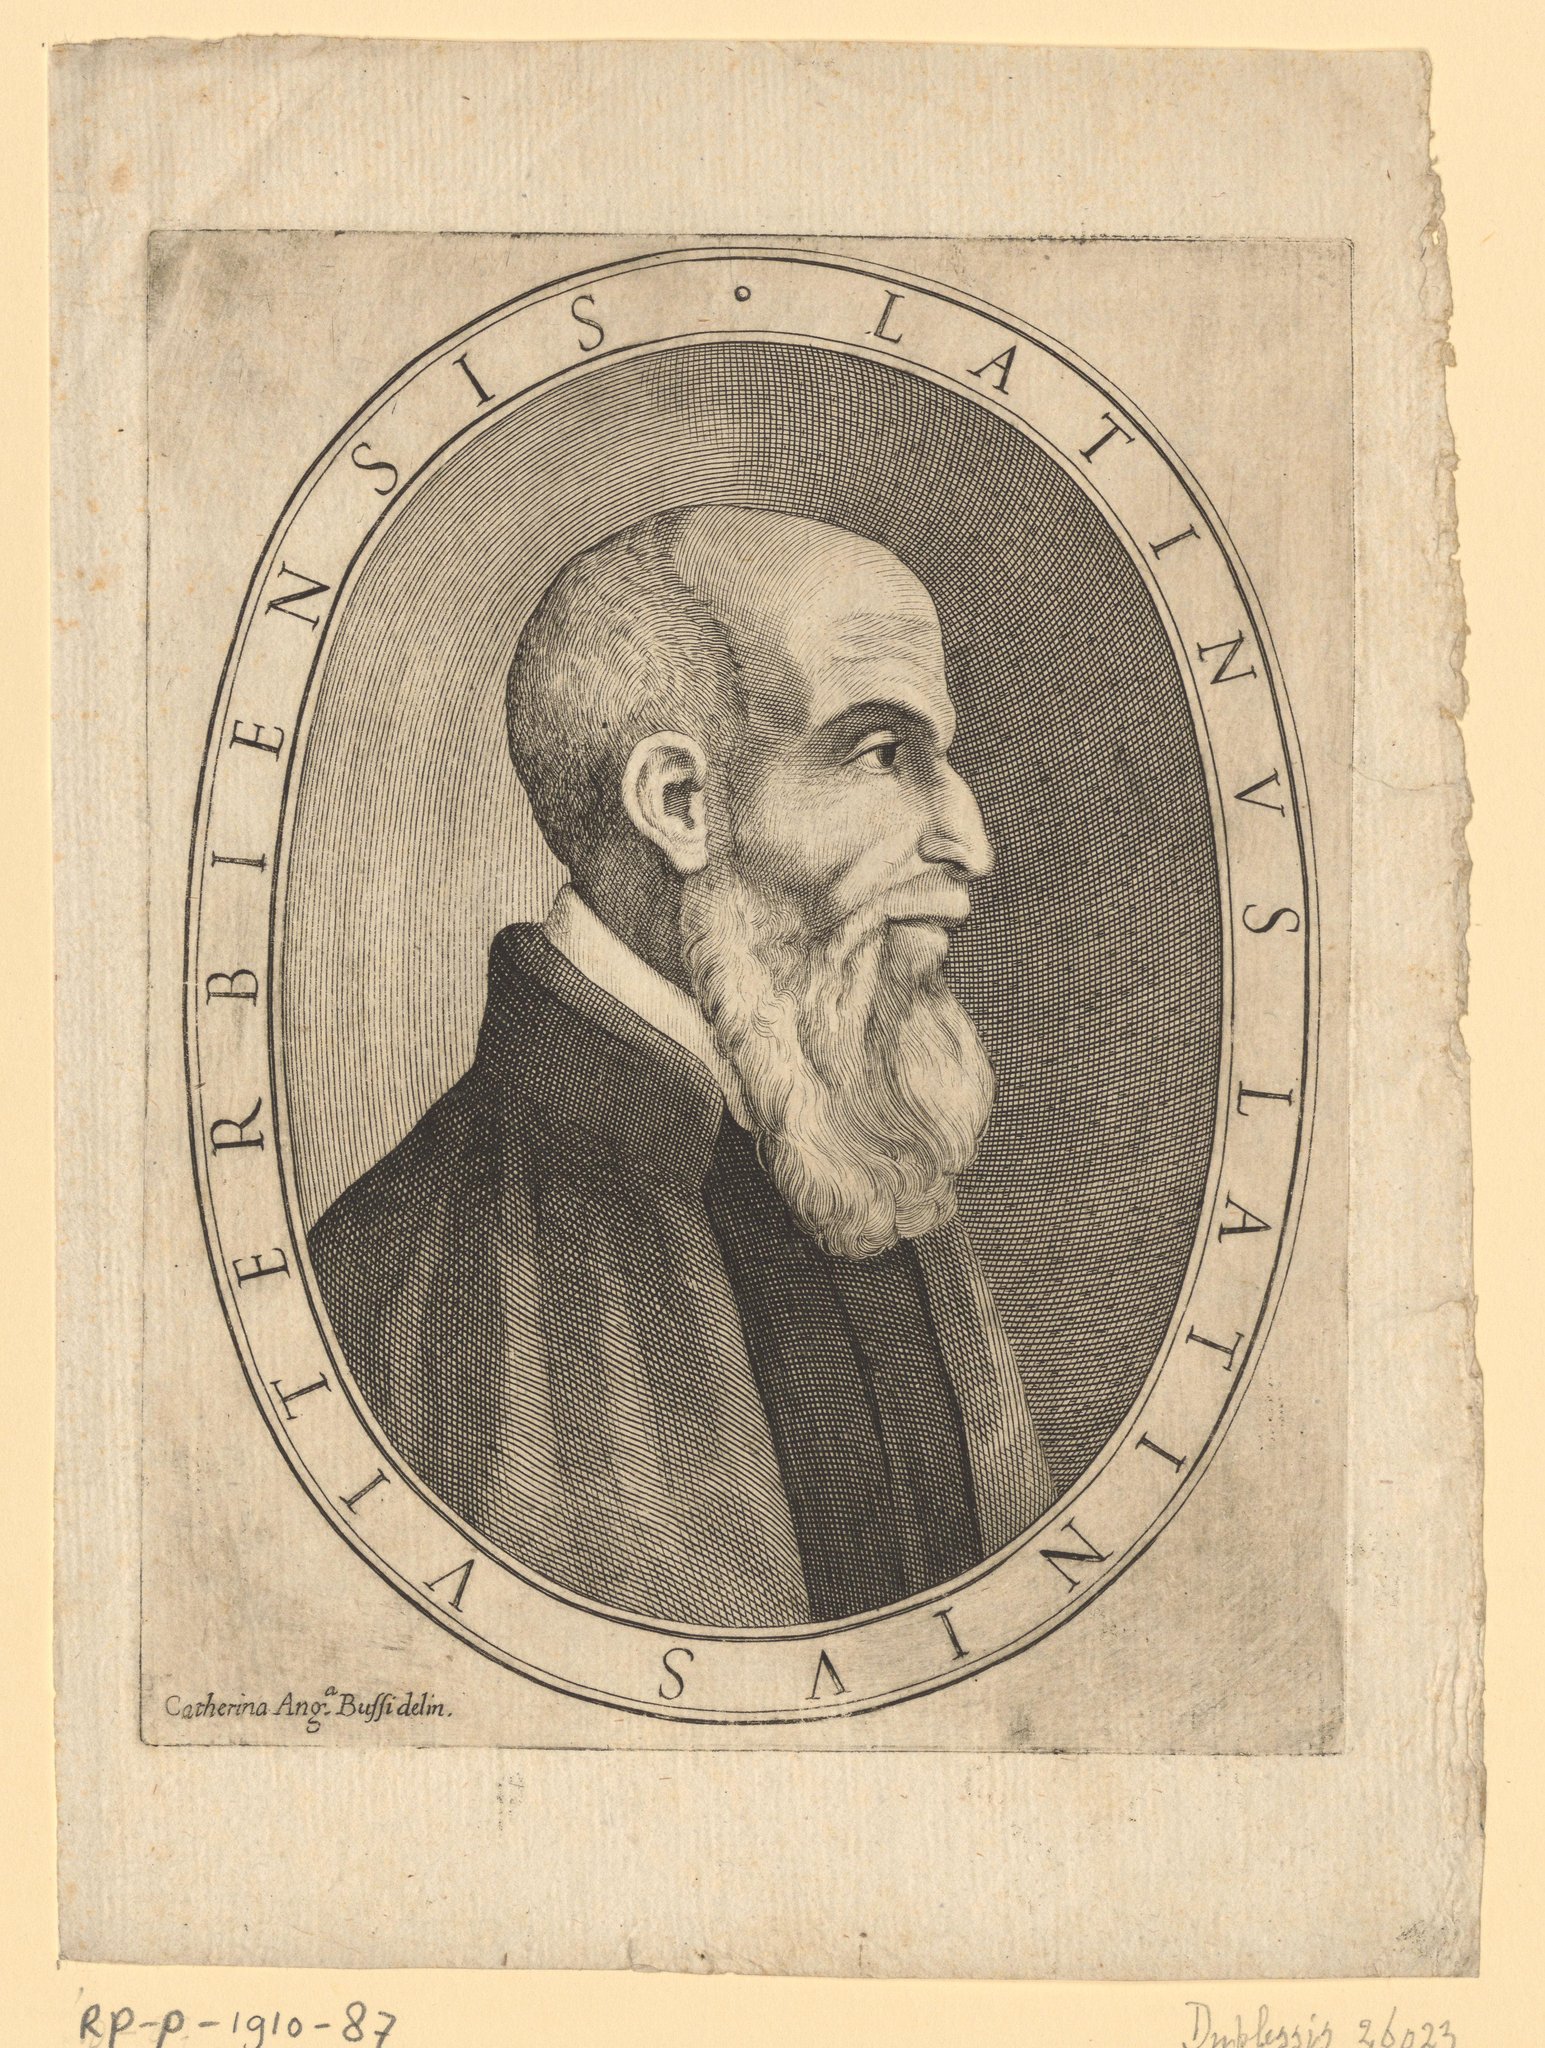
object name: print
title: Portret van Latino Latini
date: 1650-1750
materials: paper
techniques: engraving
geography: italy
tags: historical persons, scholar, philosopher (+ portrait of scholar, scientist)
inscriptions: collector's mark: Lugt 2228